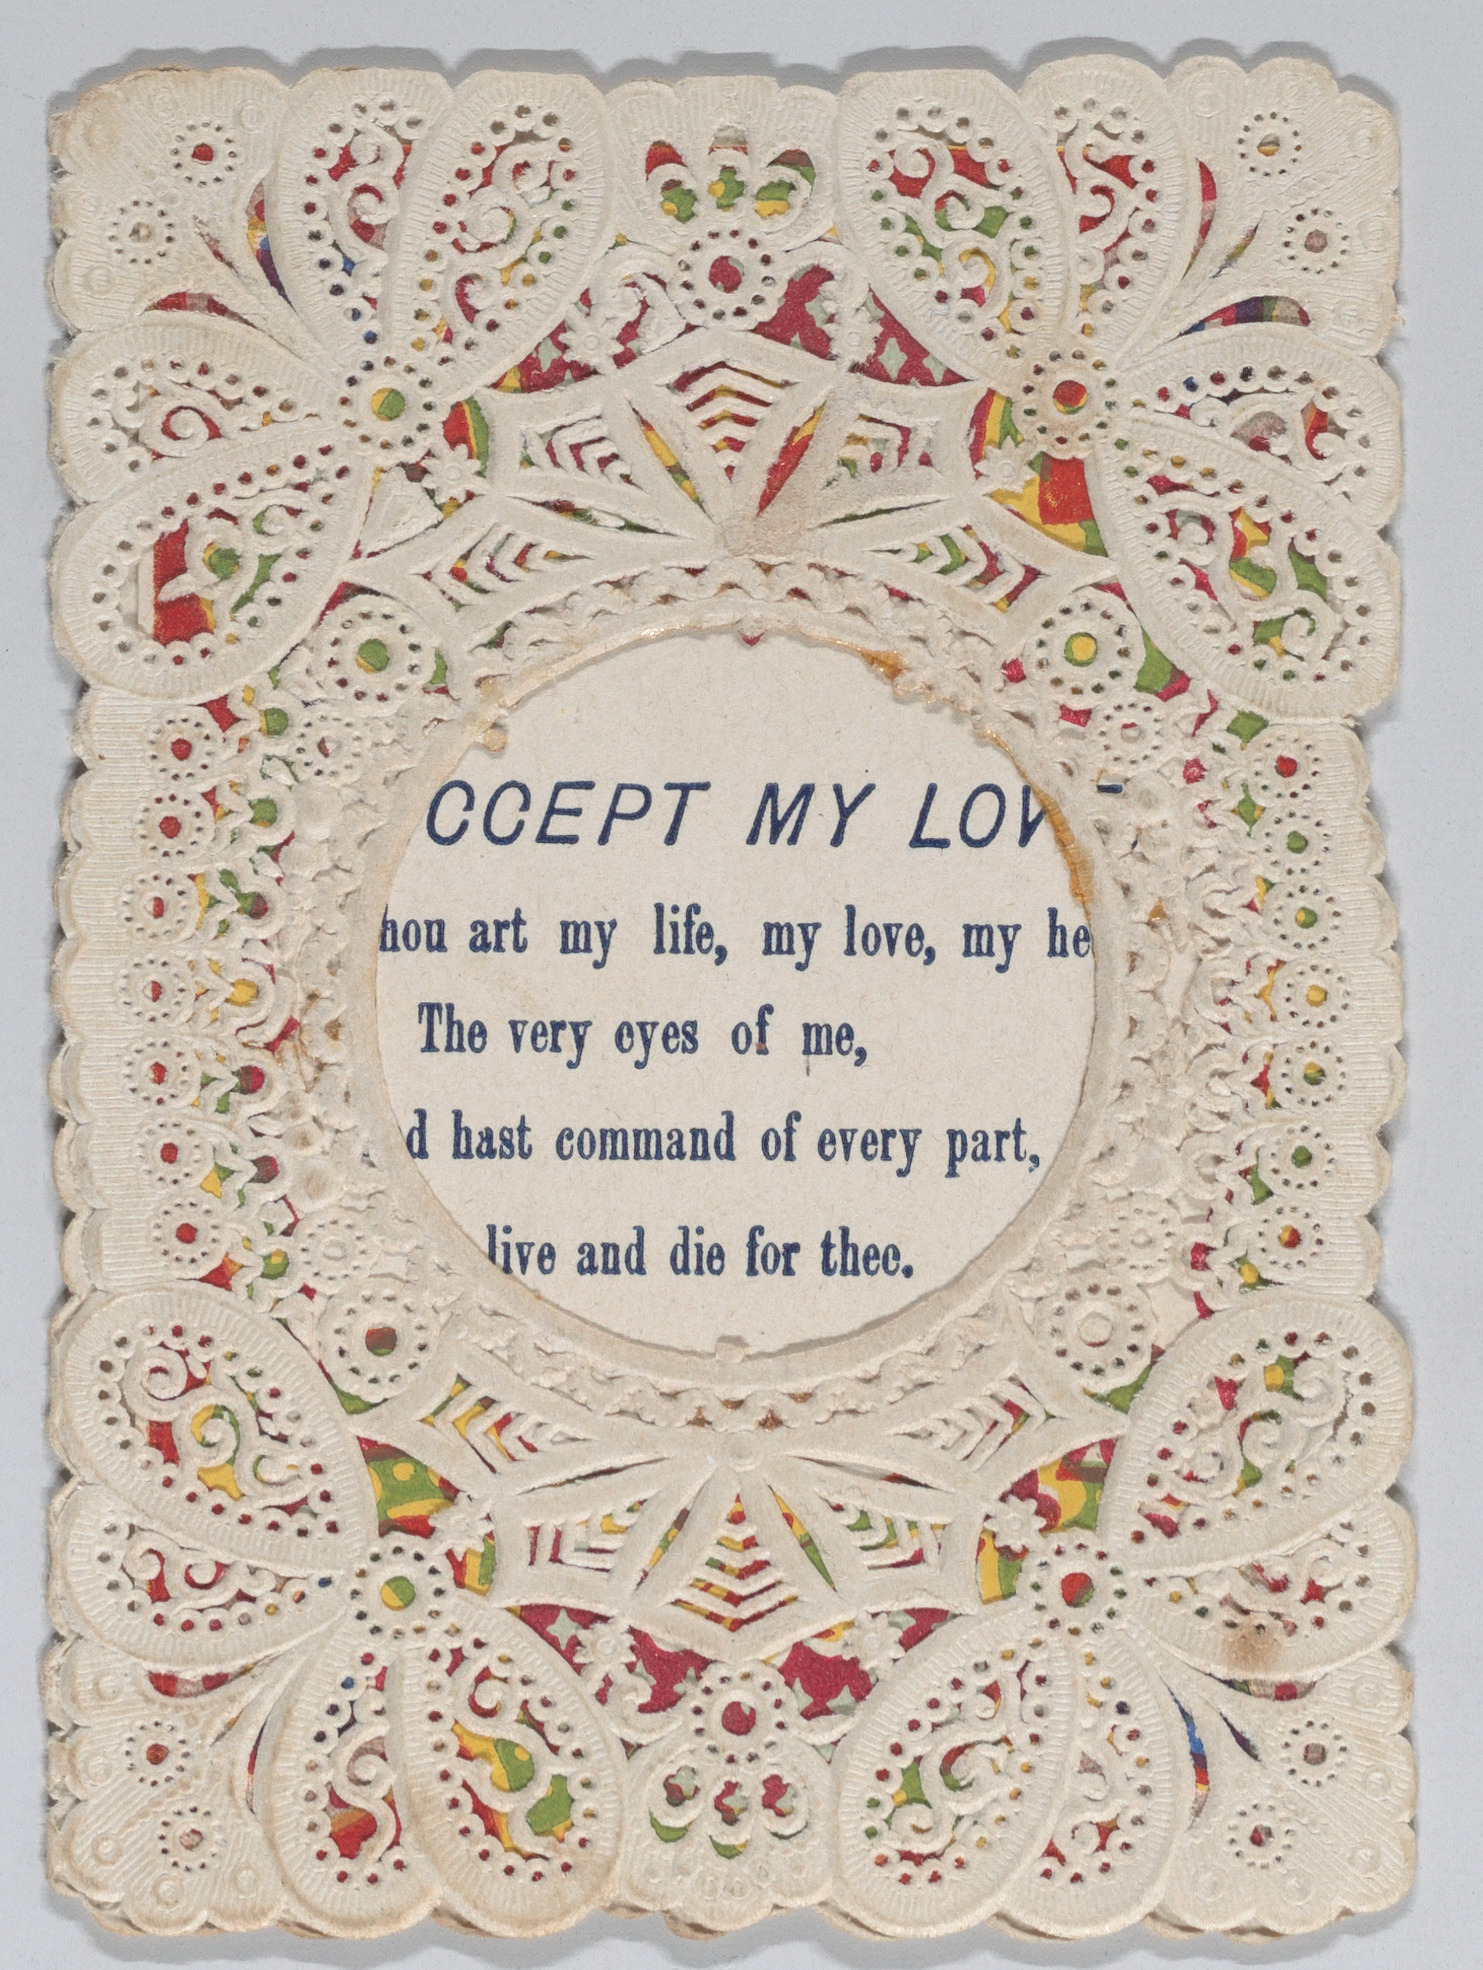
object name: valentine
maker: Anonymous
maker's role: artist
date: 1880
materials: lace, paper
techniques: chromolithography, embossing, open work